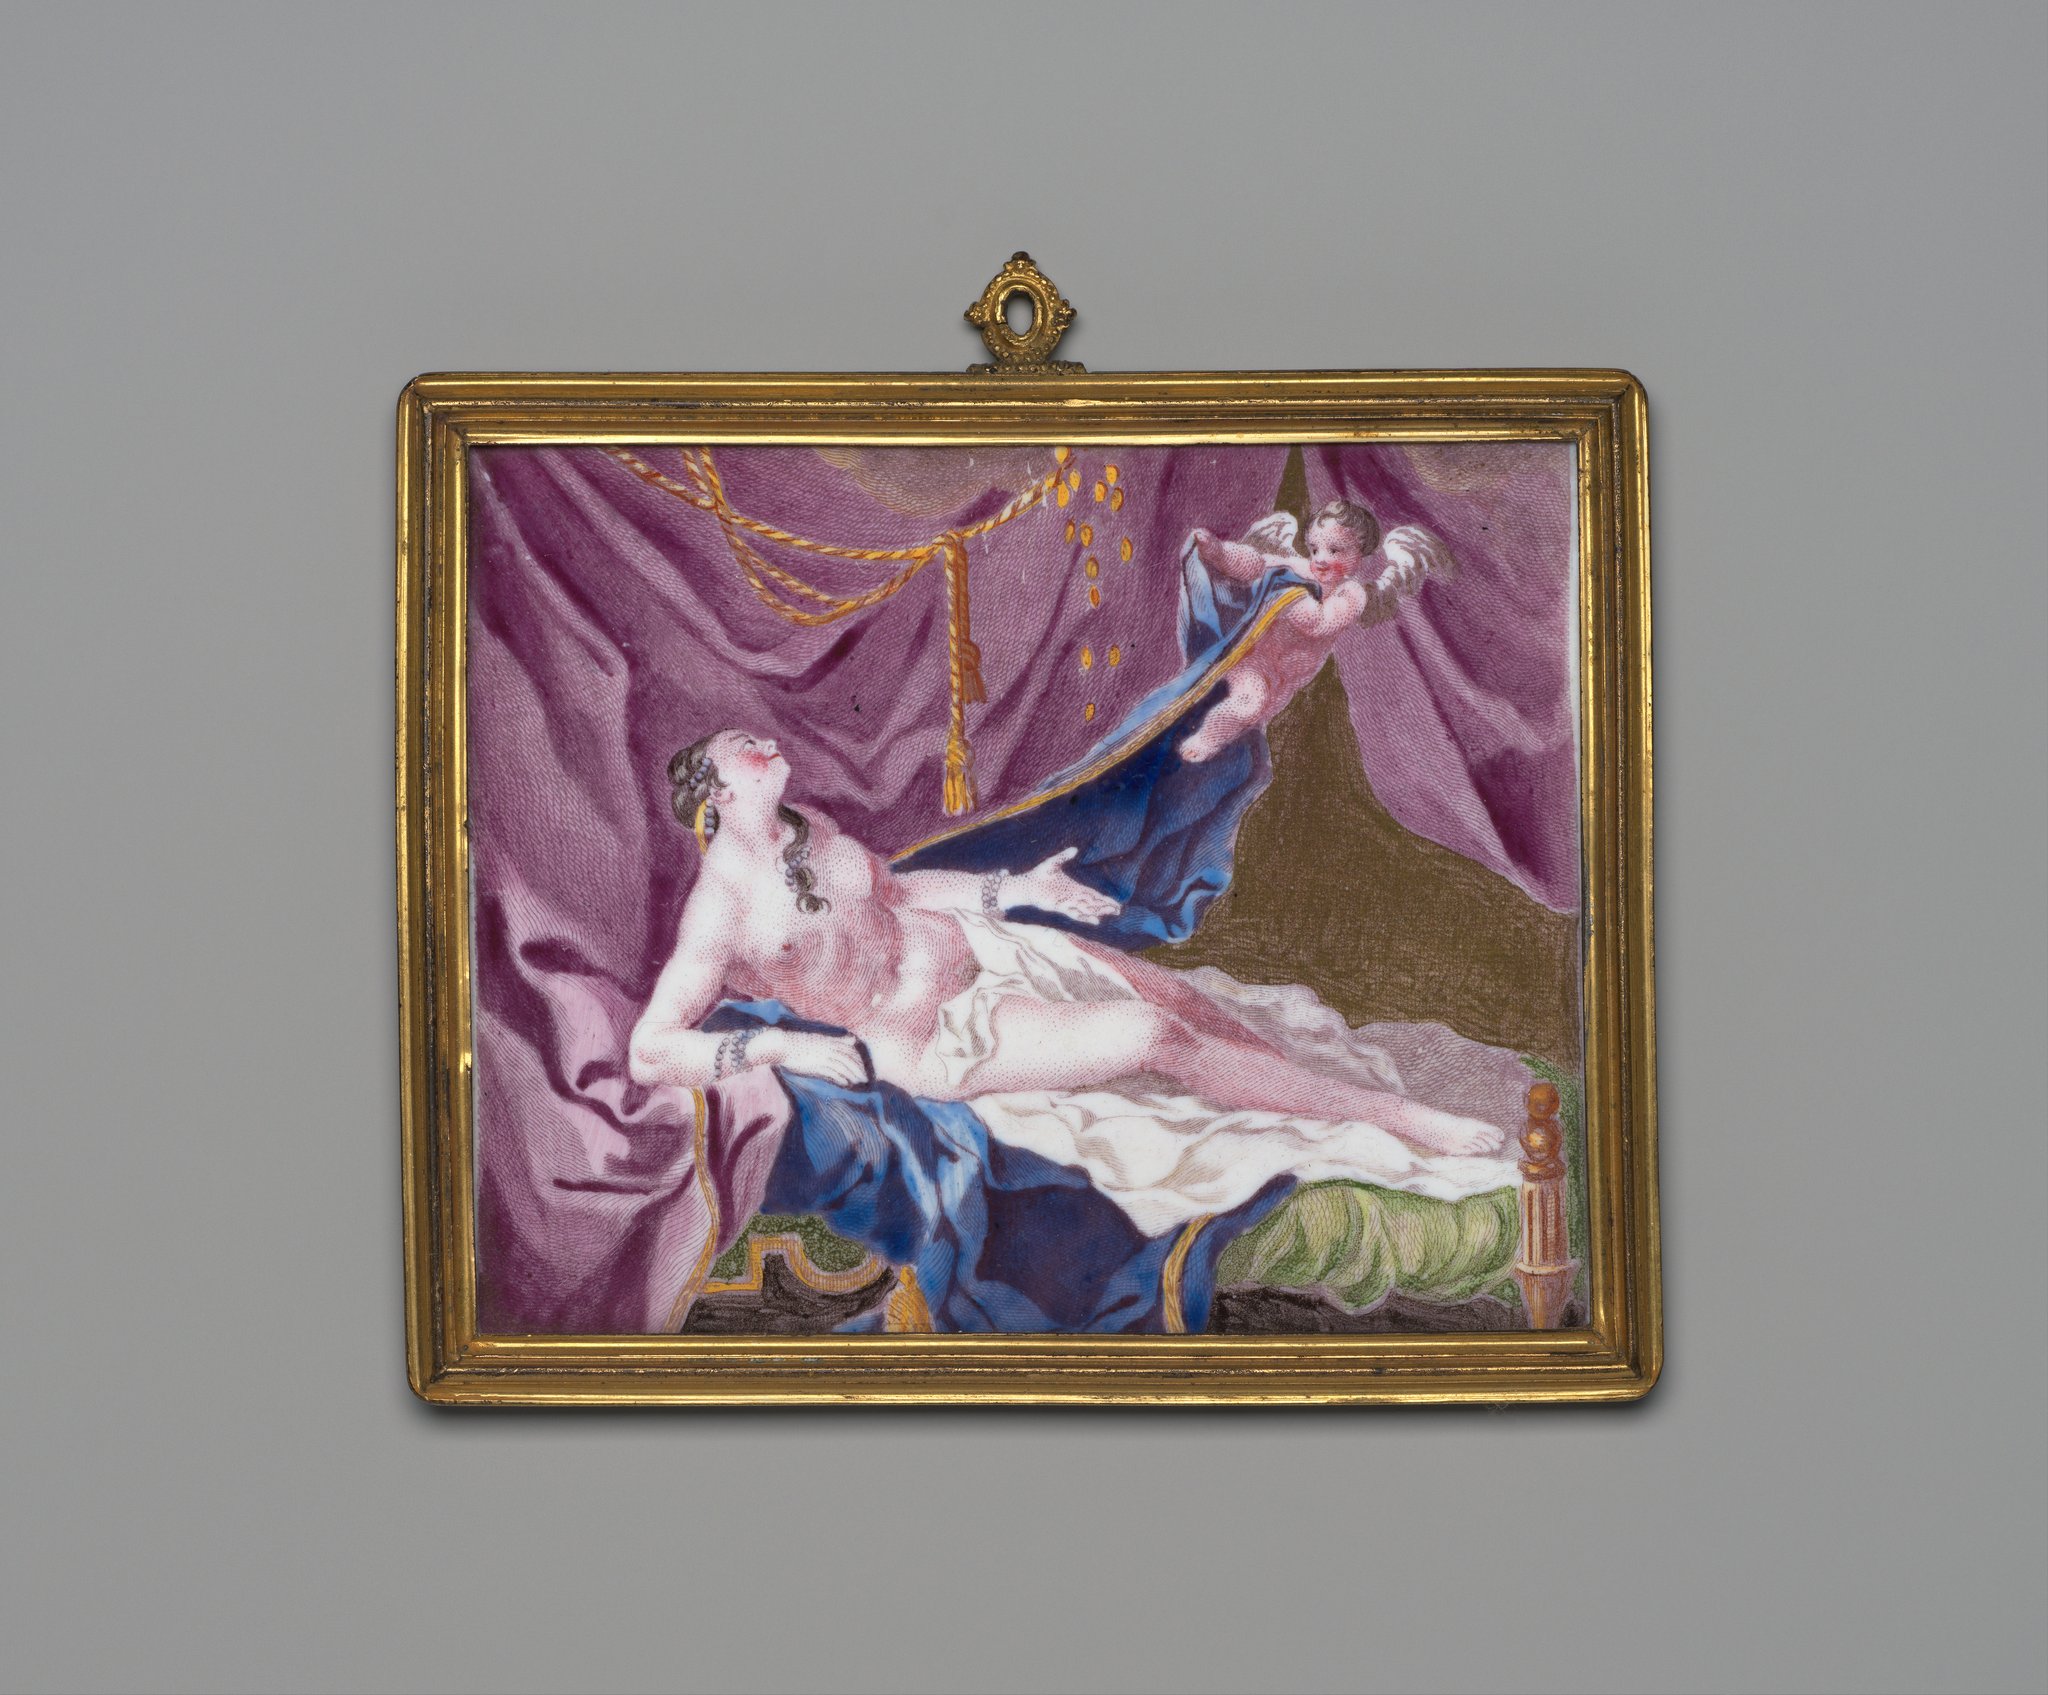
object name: plaque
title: Danae and the Shower of Gold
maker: simon francis ravenet, the elder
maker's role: artist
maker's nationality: french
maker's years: 1706-1774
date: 1753-1756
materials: copper, enamel